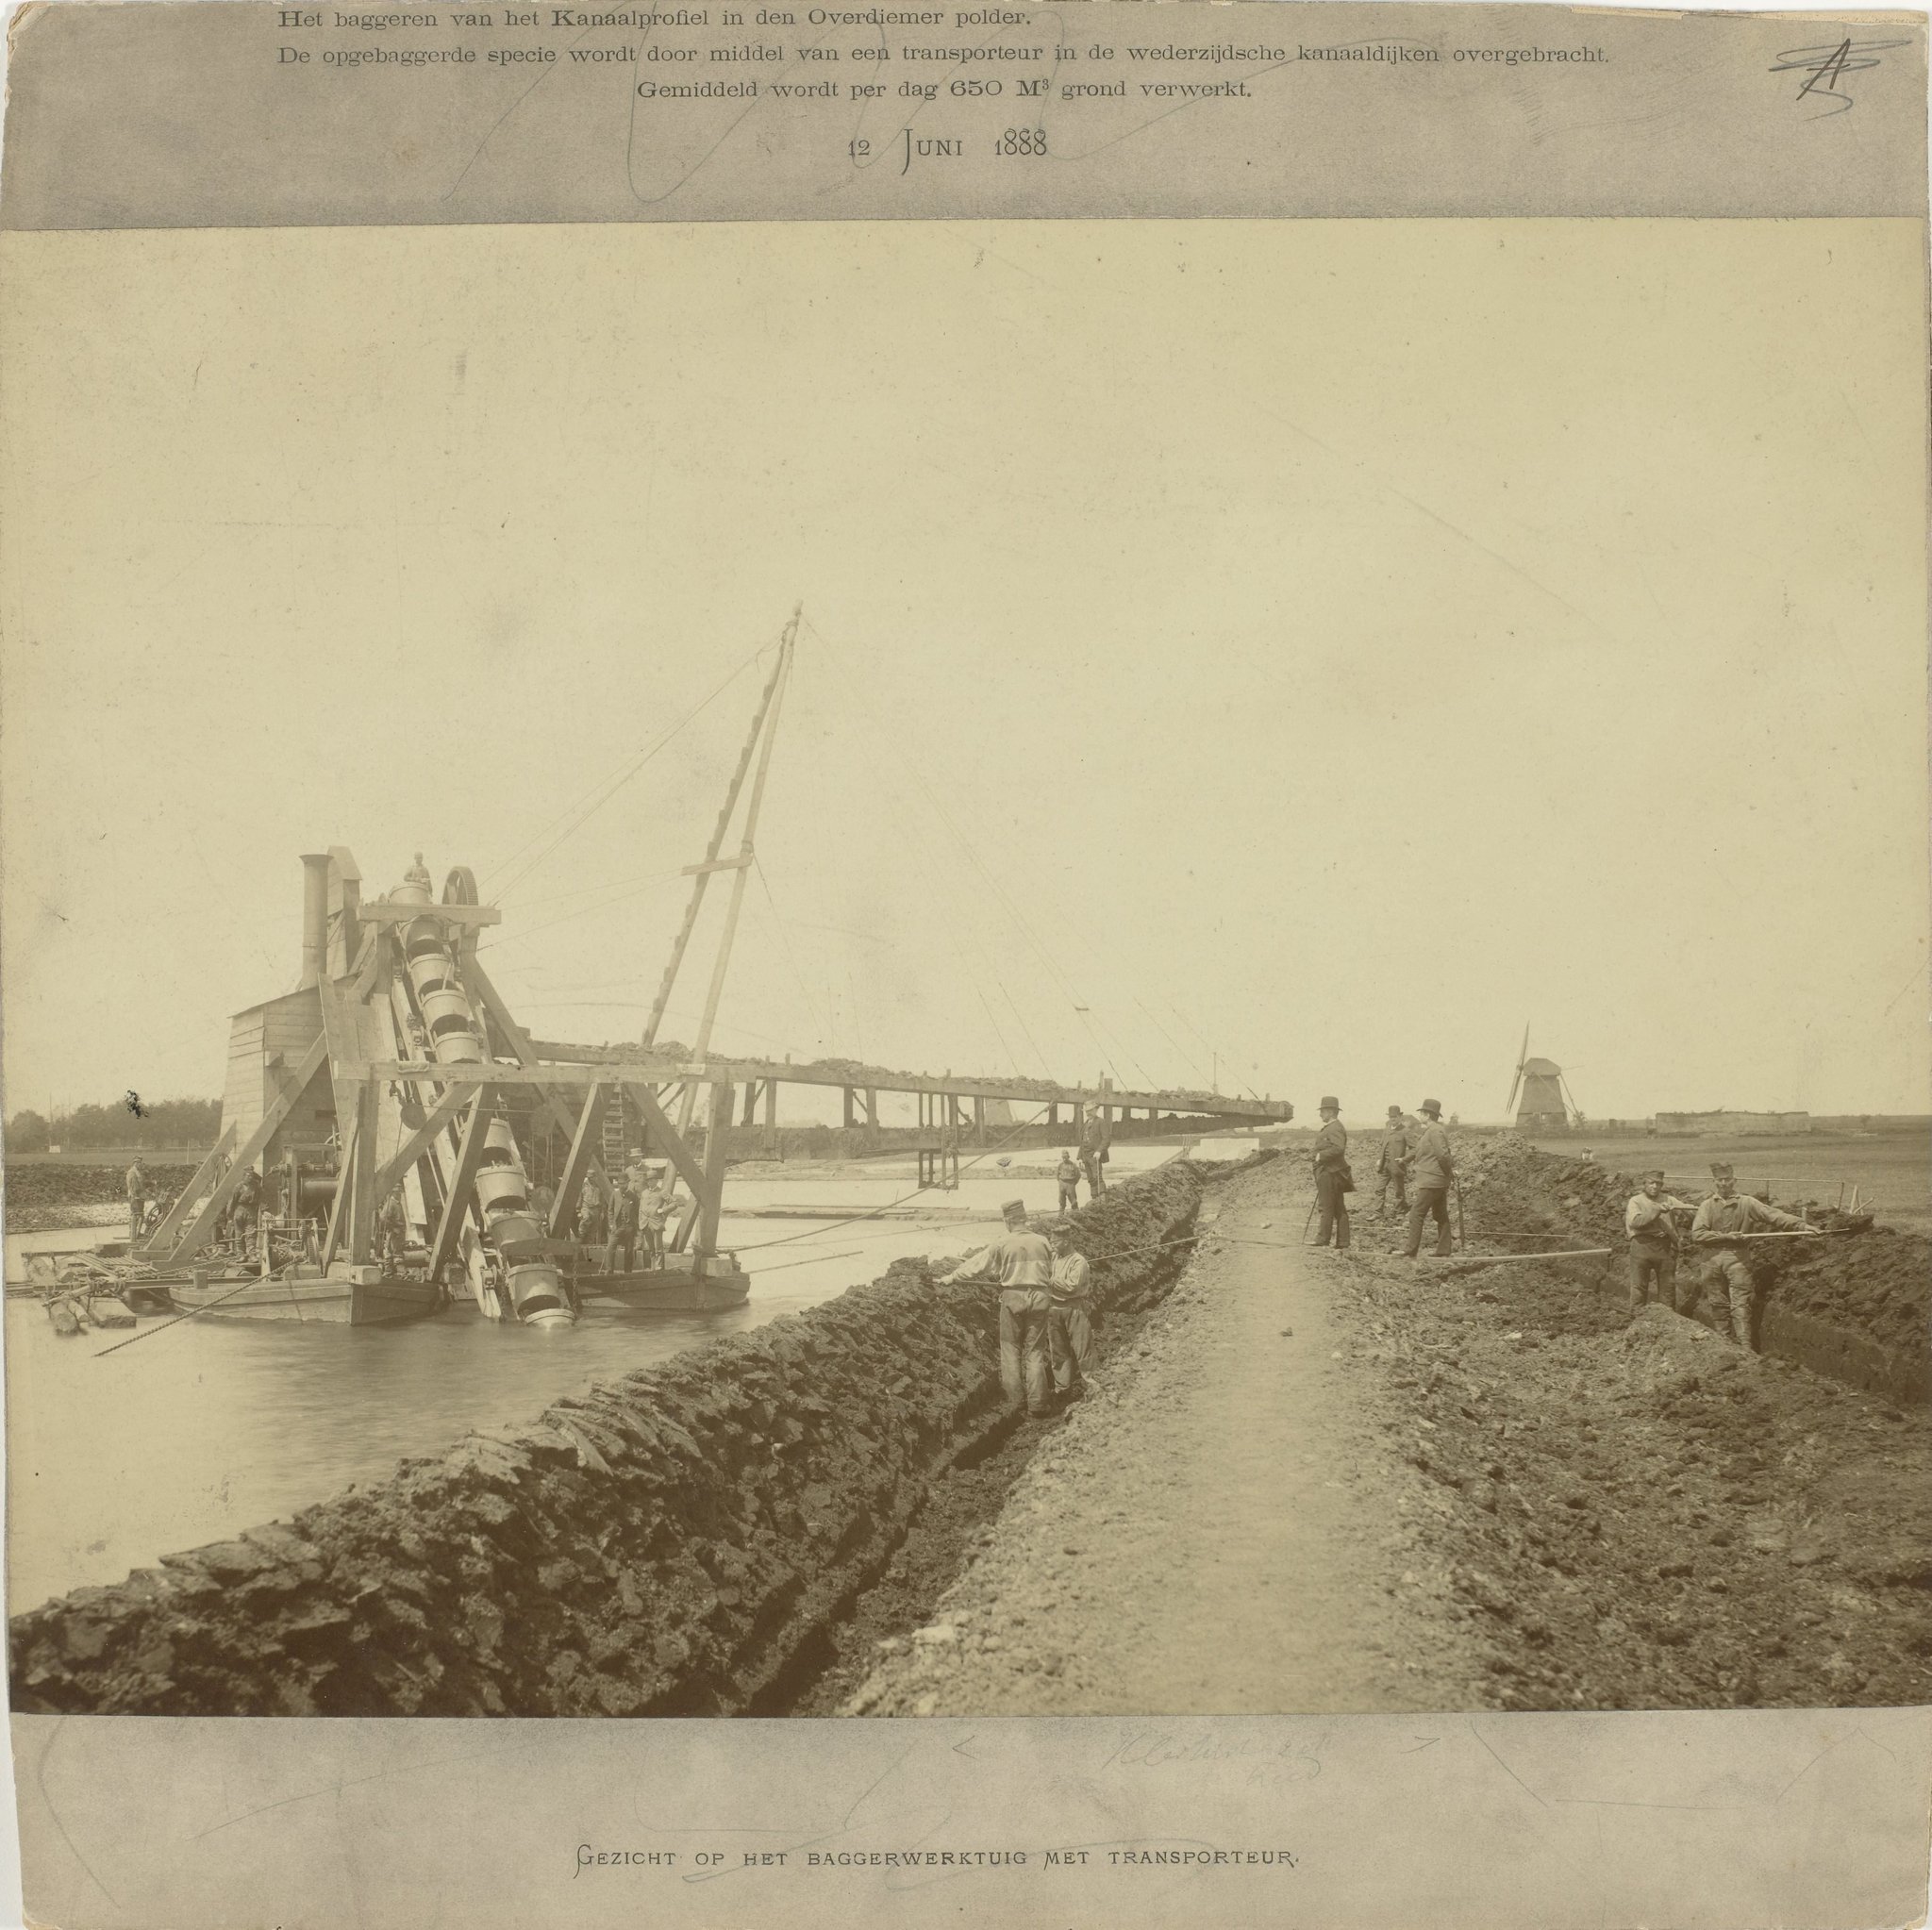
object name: photograph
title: Gezicht op het baggerwerktuig met transporteur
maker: Anonymous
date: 1888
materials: cardboard, paper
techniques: photography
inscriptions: date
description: Foto op karton, van waterbouwkundige werken. Gedateerd.